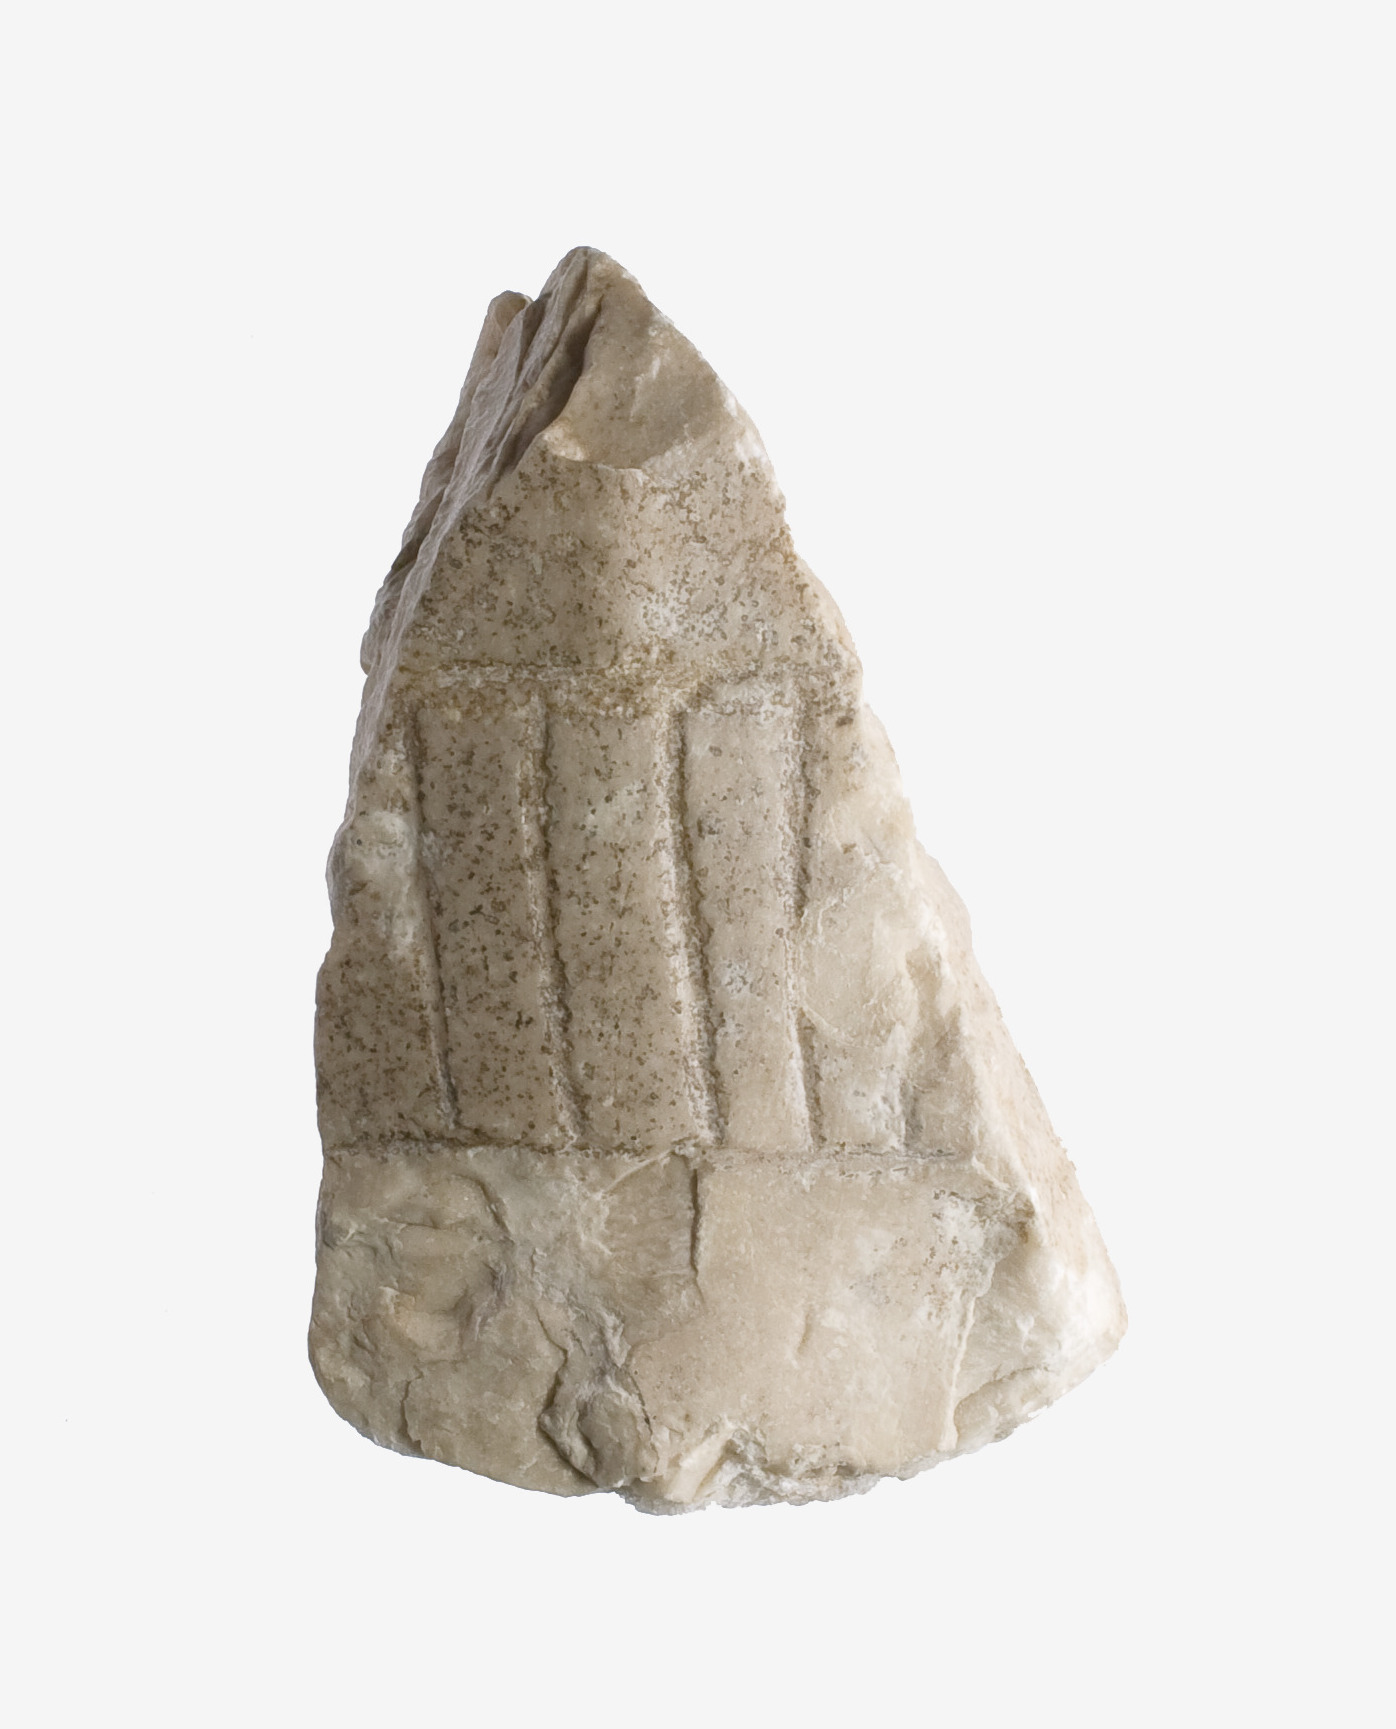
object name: ankle, selvage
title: Ankle with selvage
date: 1353-1336 BCE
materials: limestone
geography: egypt